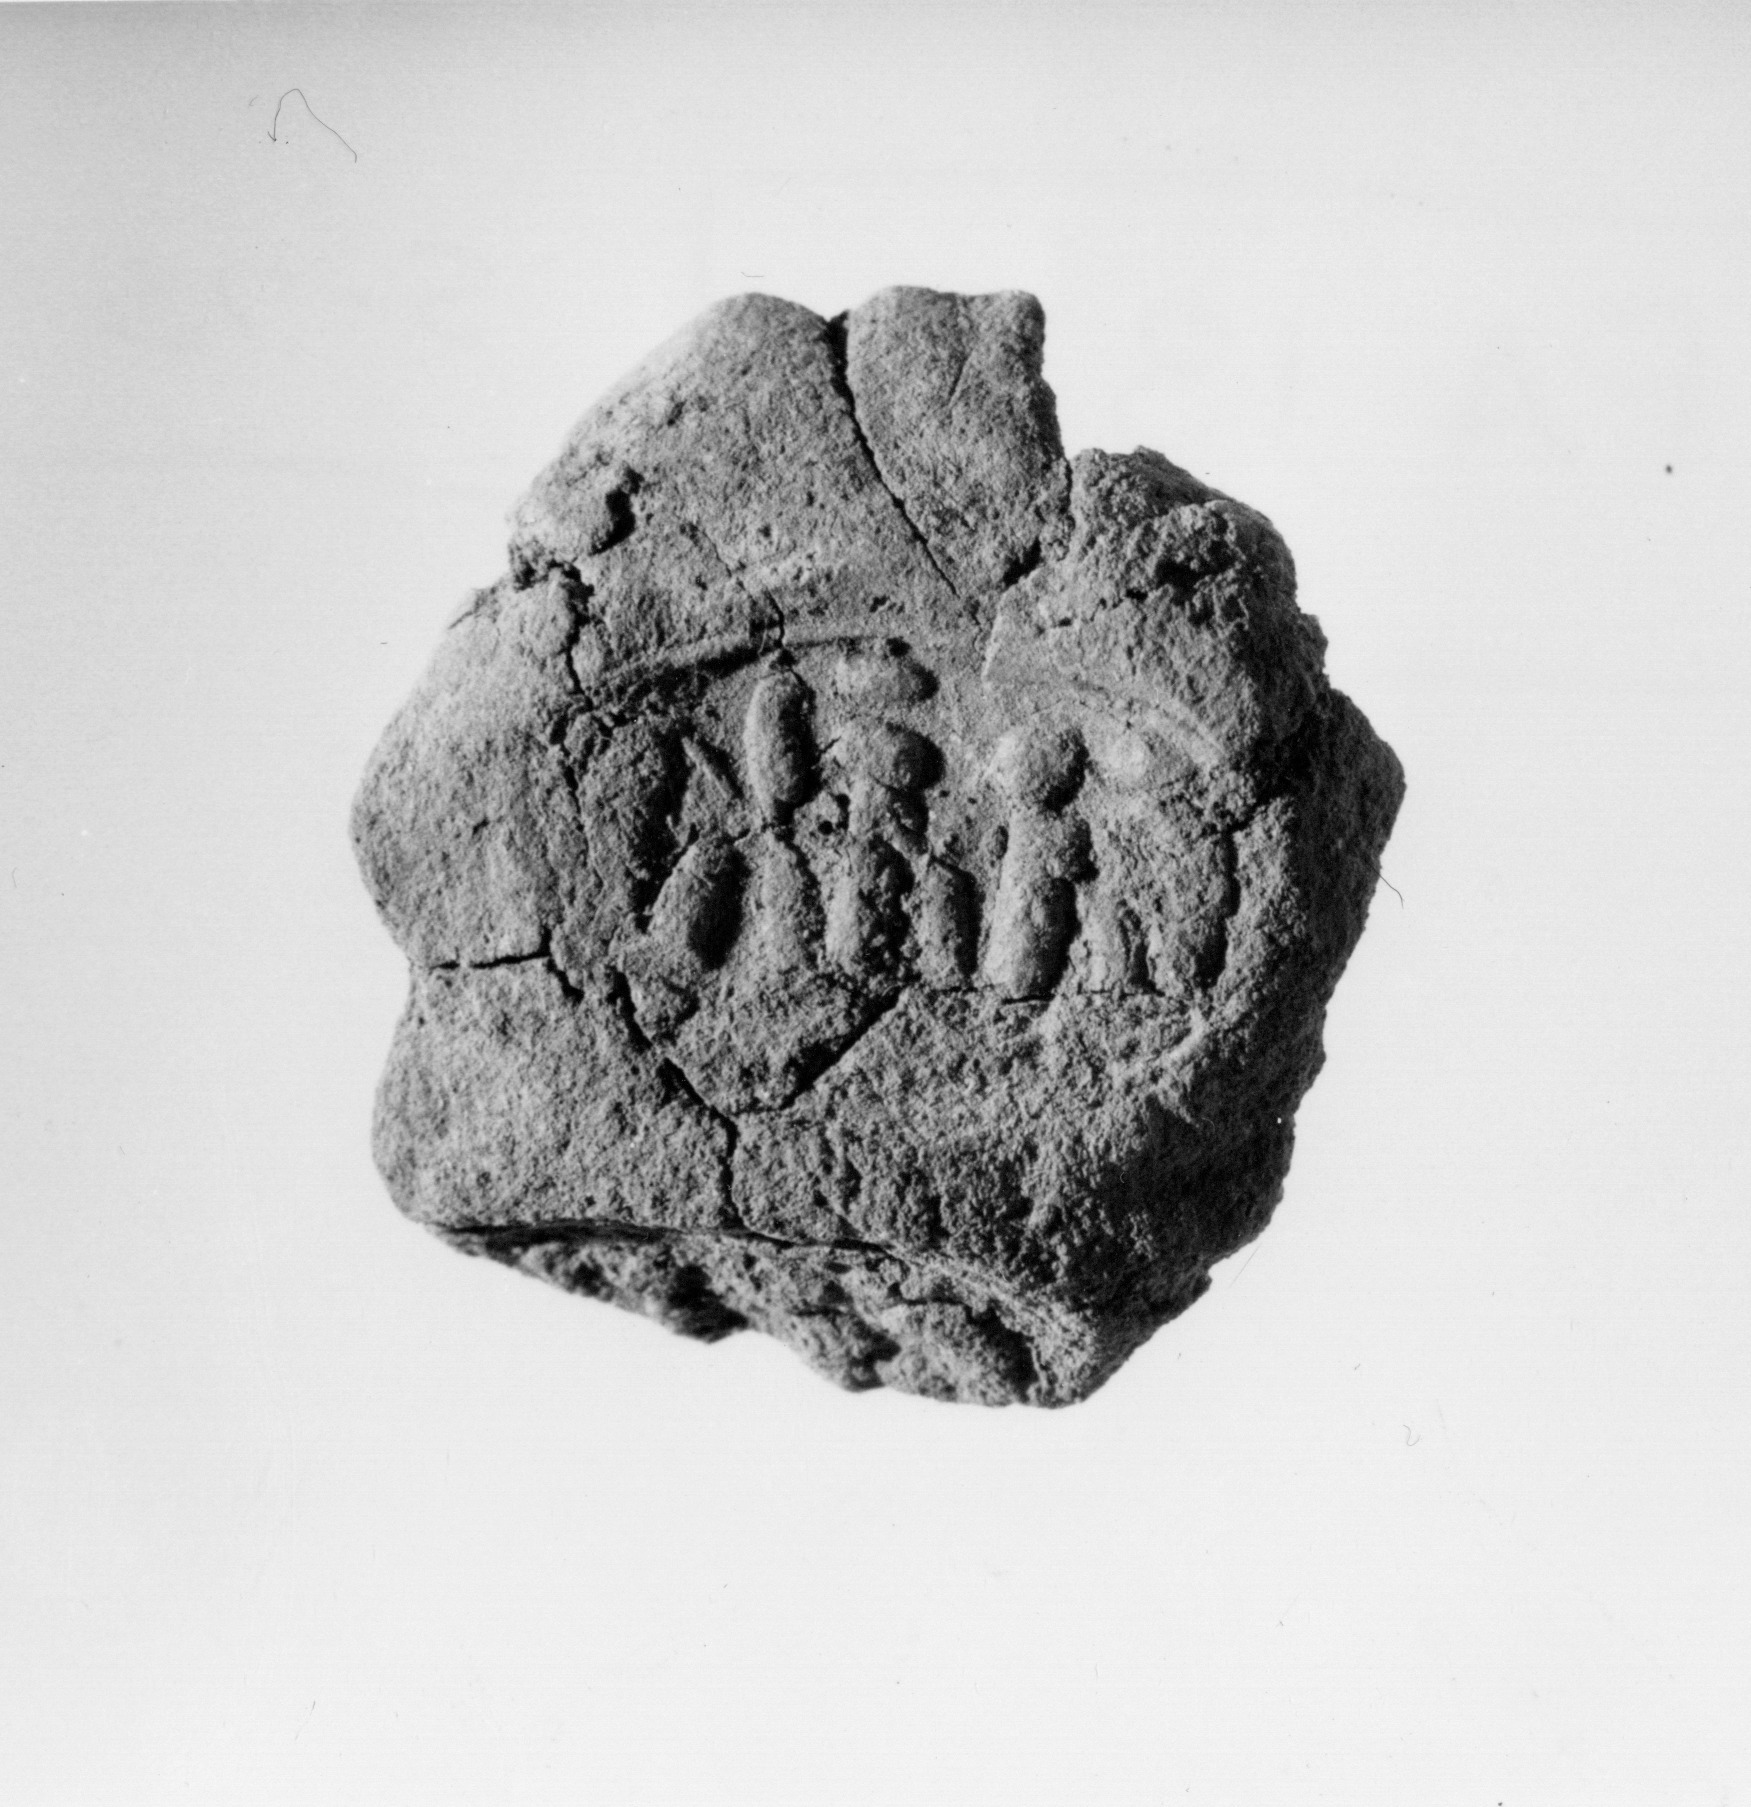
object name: sealing, nebmaatre, amenhotep iii, thoth, ptah, re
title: Document Sealing With the Throne Name of Amenhotep III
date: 1390-1352 BCE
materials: mud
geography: egypt